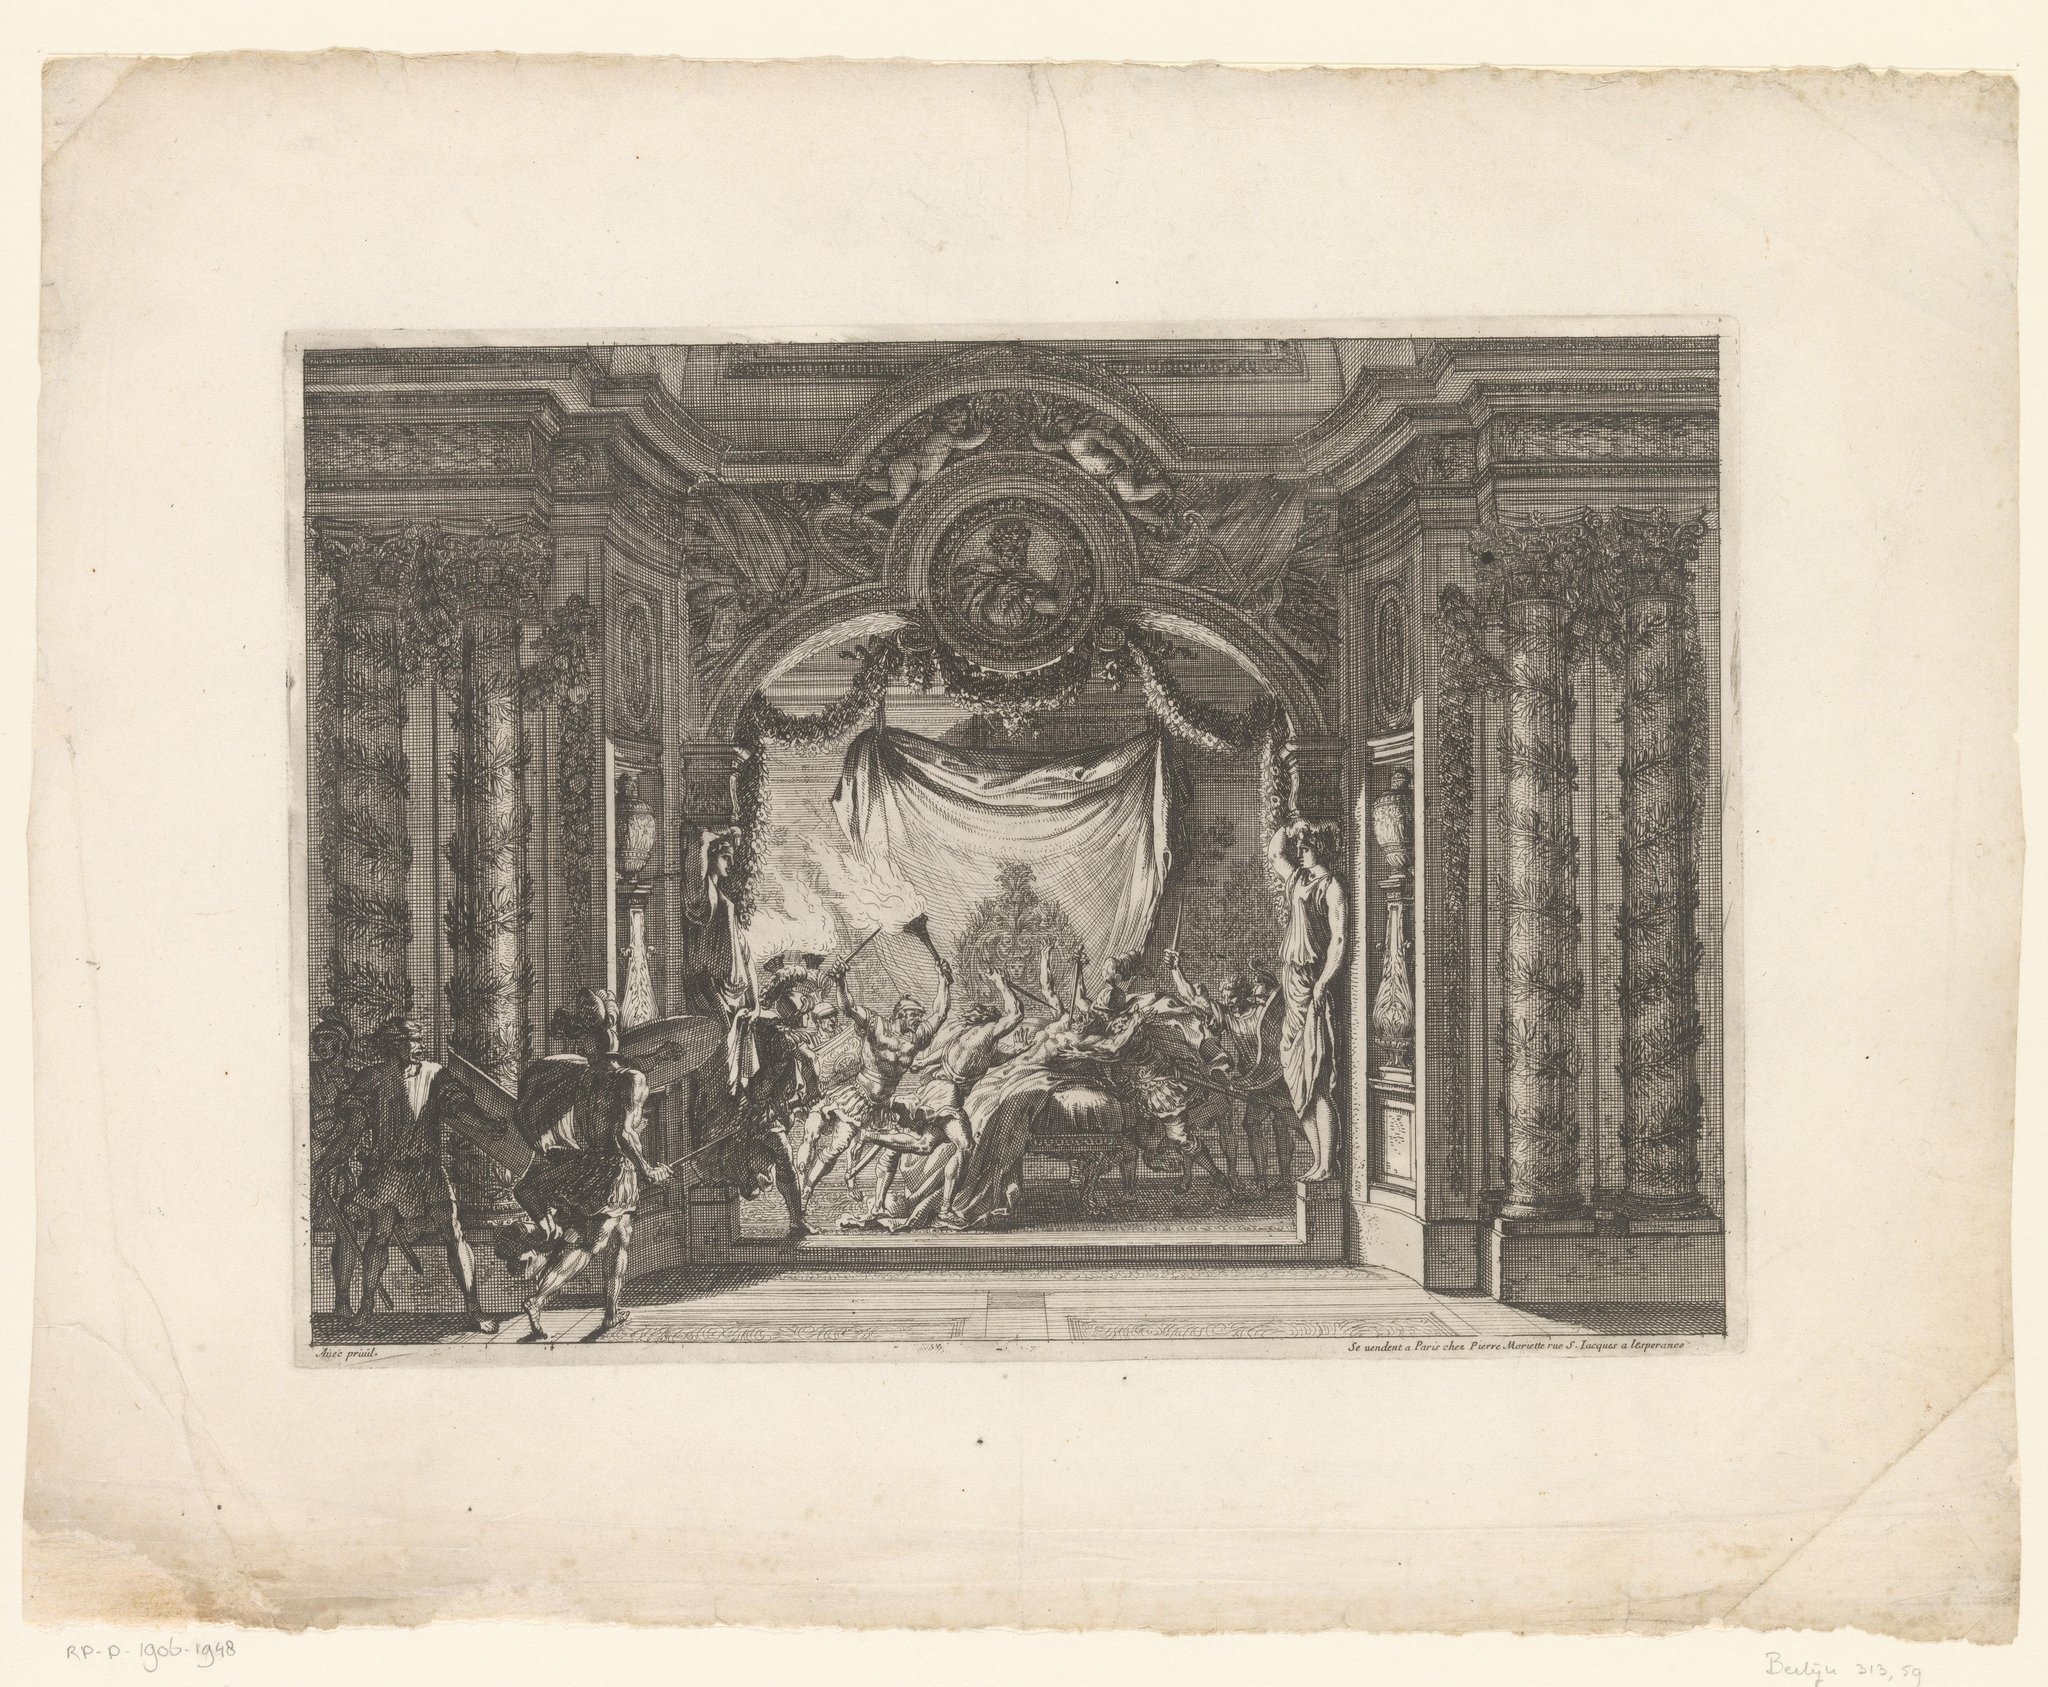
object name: print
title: Grands Alcoves a la Romaine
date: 1667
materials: paper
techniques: etching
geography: paris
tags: violent death by sword, murder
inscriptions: collector's mark: Lugt 2228, inscription: ‘15a / 20-10-'81’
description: Een man op bed wordt doodgestoken door diverse soldaten. Links staan soldaten met fakkels. Links in de voorgrond komen nog meer soldaten aanlopen.